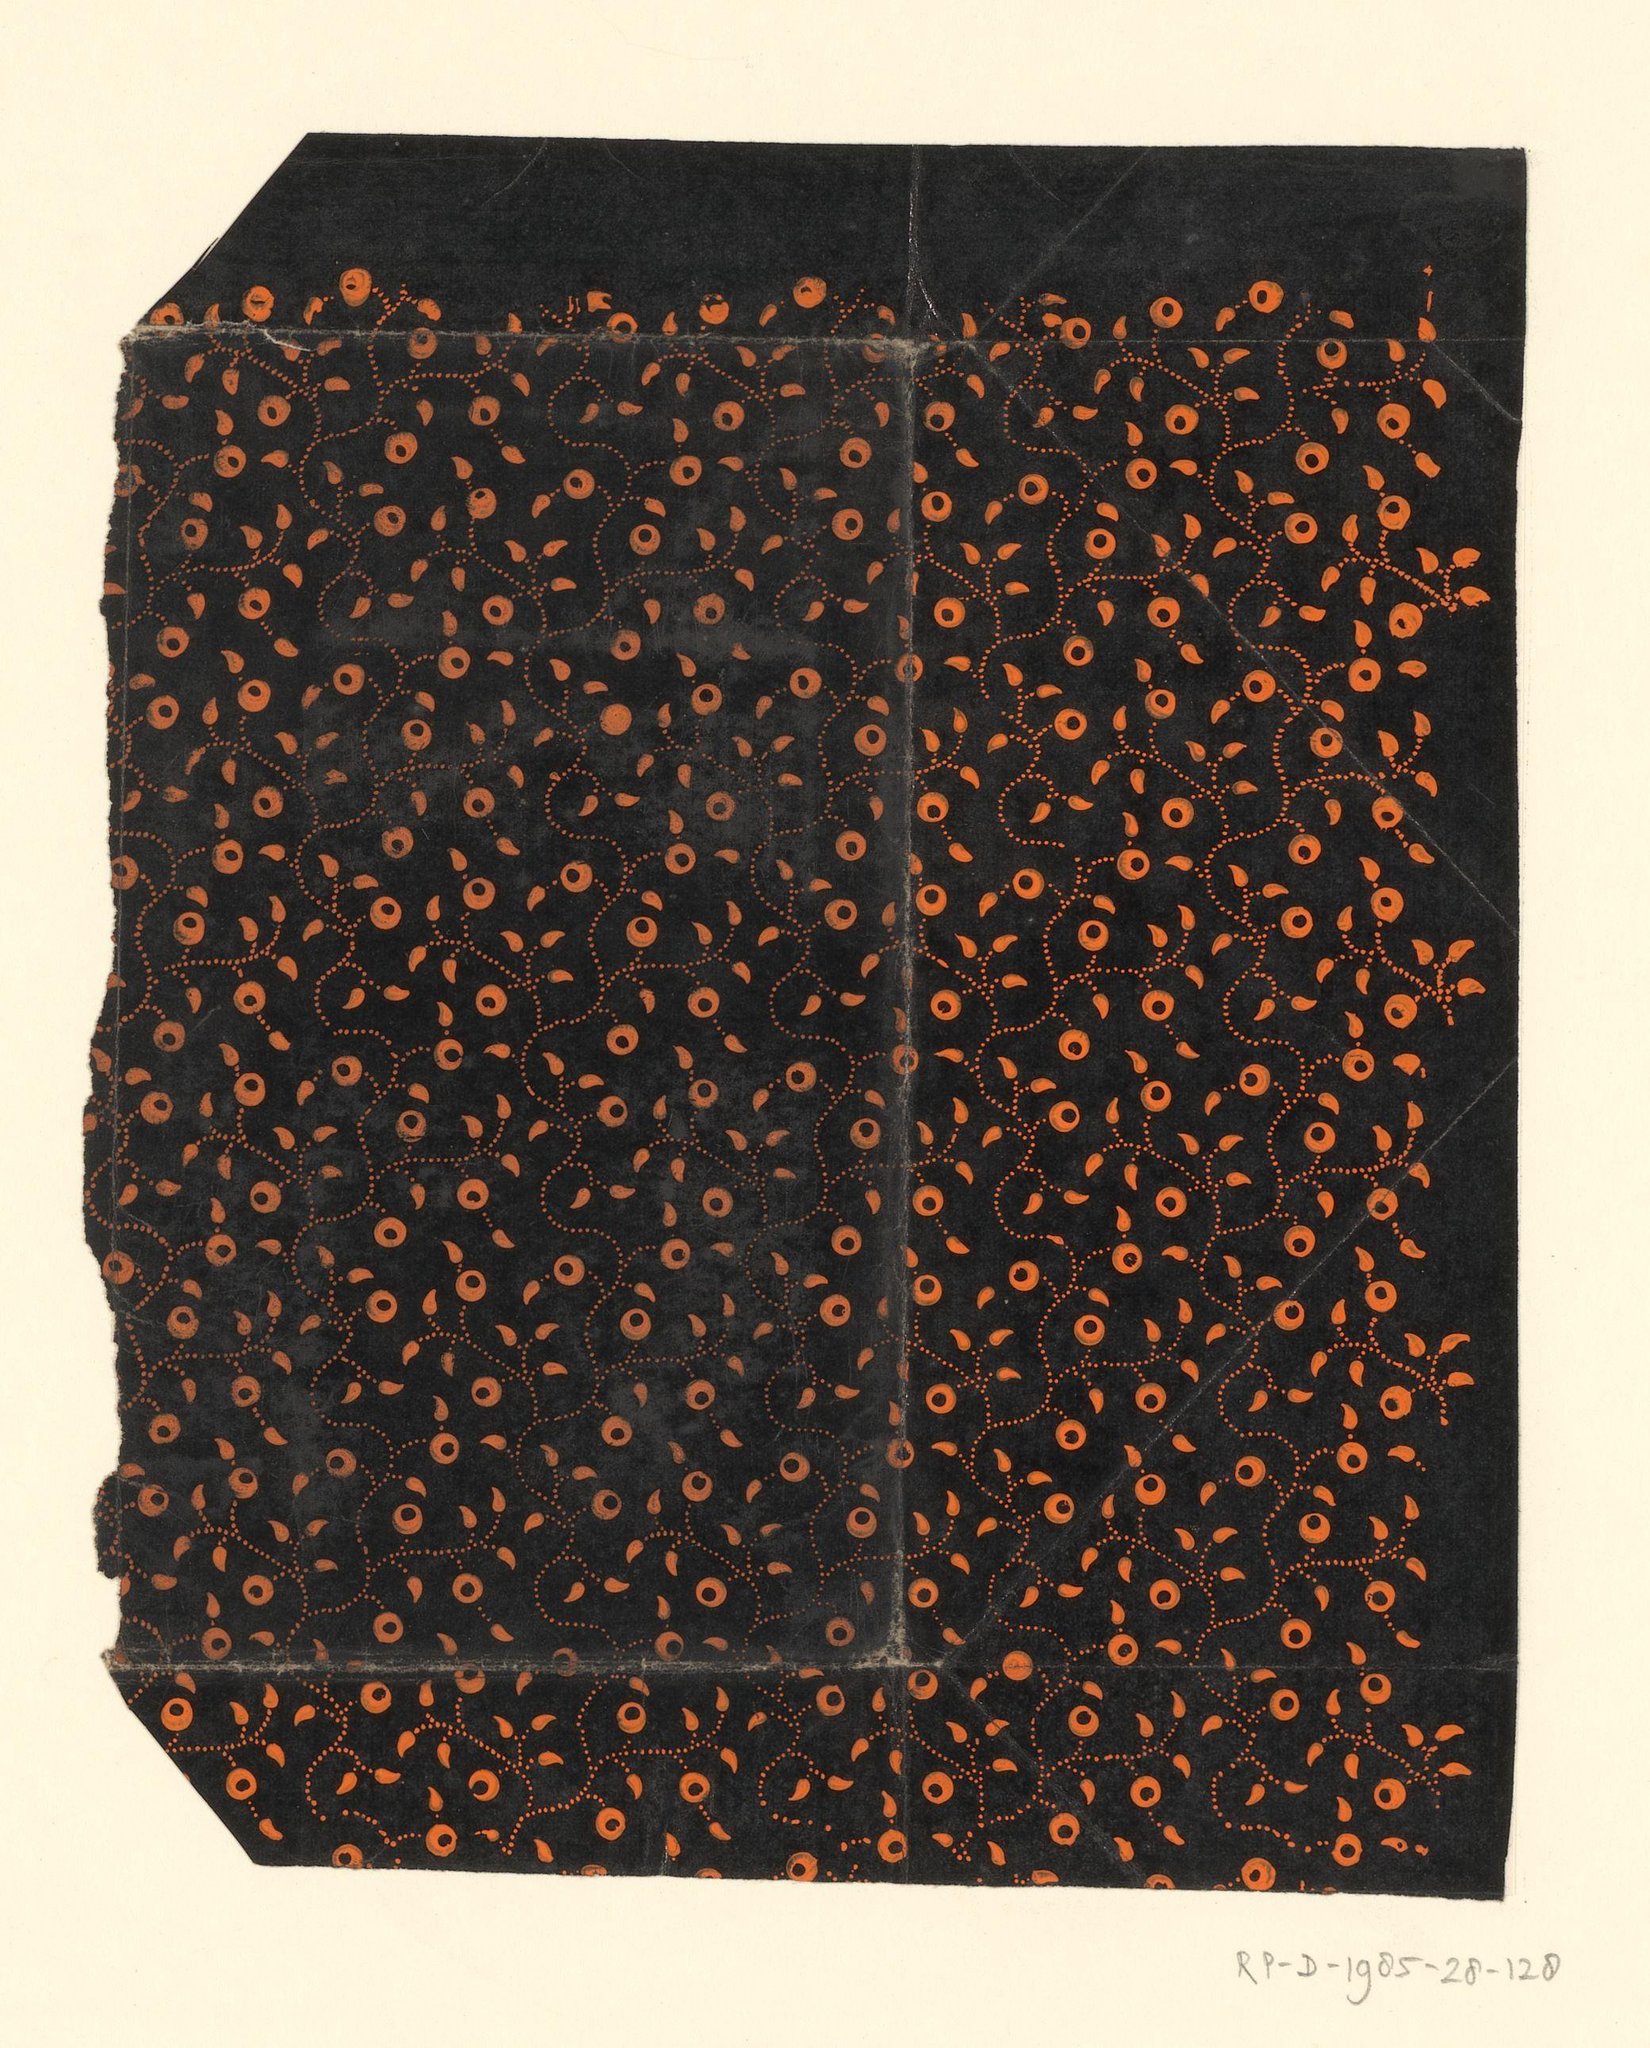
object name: printed paper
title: Blad met strooipatroon van ranken met vruchten en blaadjes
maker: Anonymous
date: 1750-1900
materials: lacquer, paper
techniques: printing block, lacquer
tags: ornament derived from plant forms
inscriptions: collector's mark: Lugt 2228, collector's mark: Lugt 2760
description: Blad met strooipatroon van ranken met vruchten en blaadjes. Helft van een opengeslagen omslag.